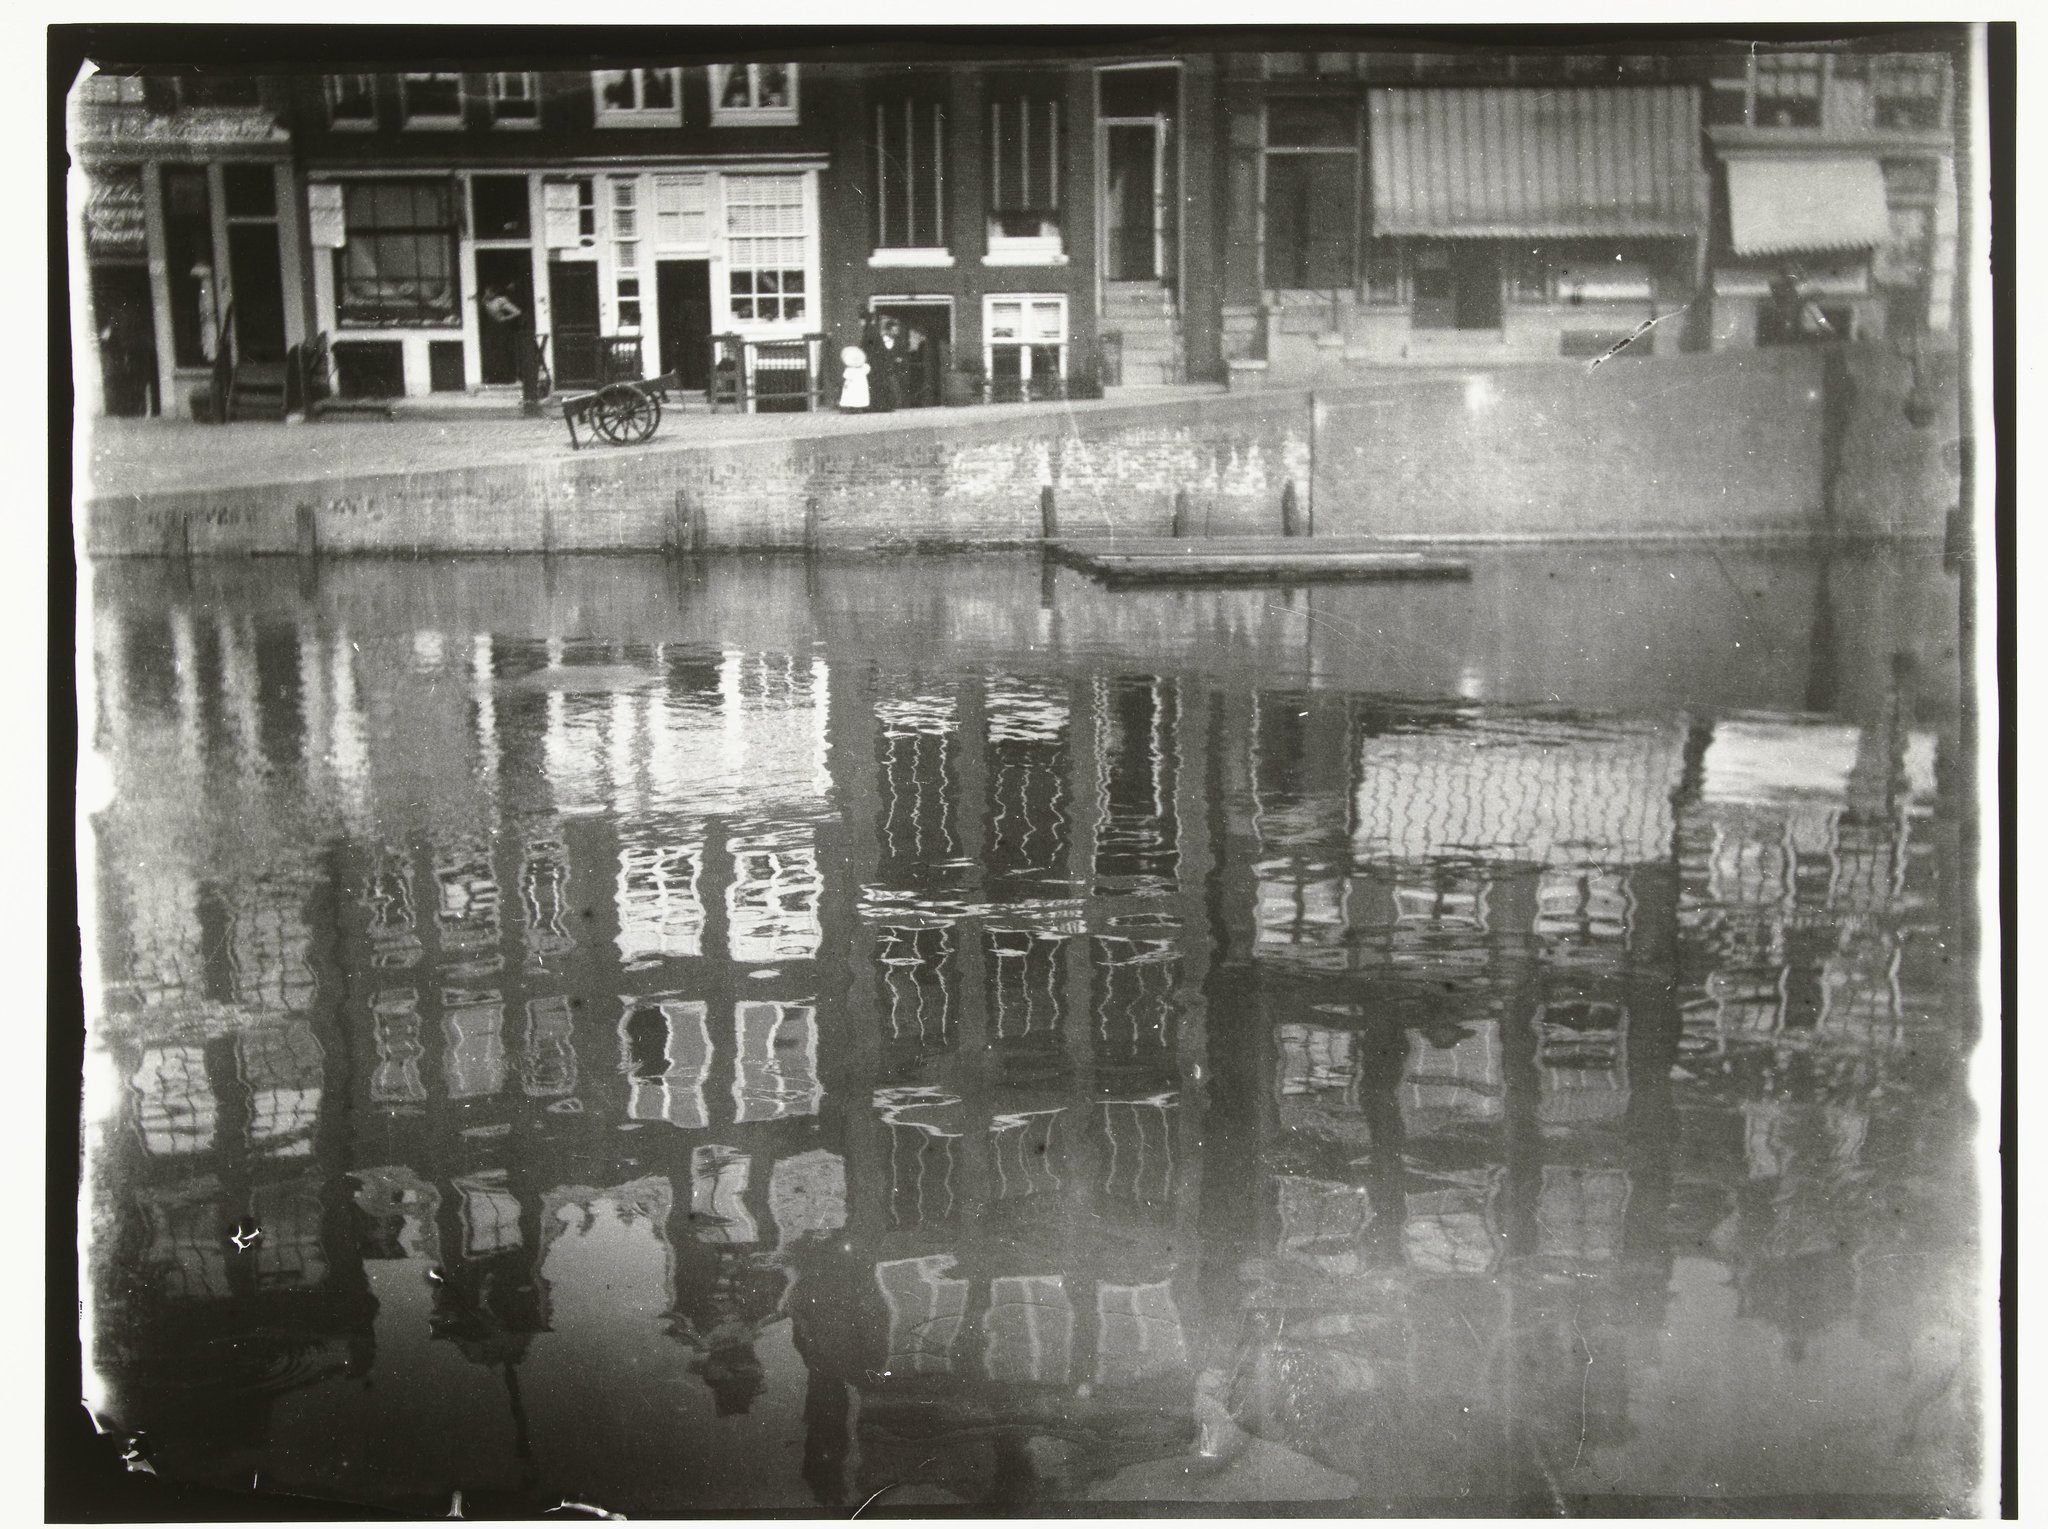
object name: photograph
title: Spiegeling van grachtenhuizen in het water op het Singel 377 tot en met 385 te Amsterdam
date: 1890-1910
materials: paper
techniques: gelatin silver print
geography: netherlands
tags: amsterdam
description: Moderne afdruk van negatief BR 1933 (collectie RKD).